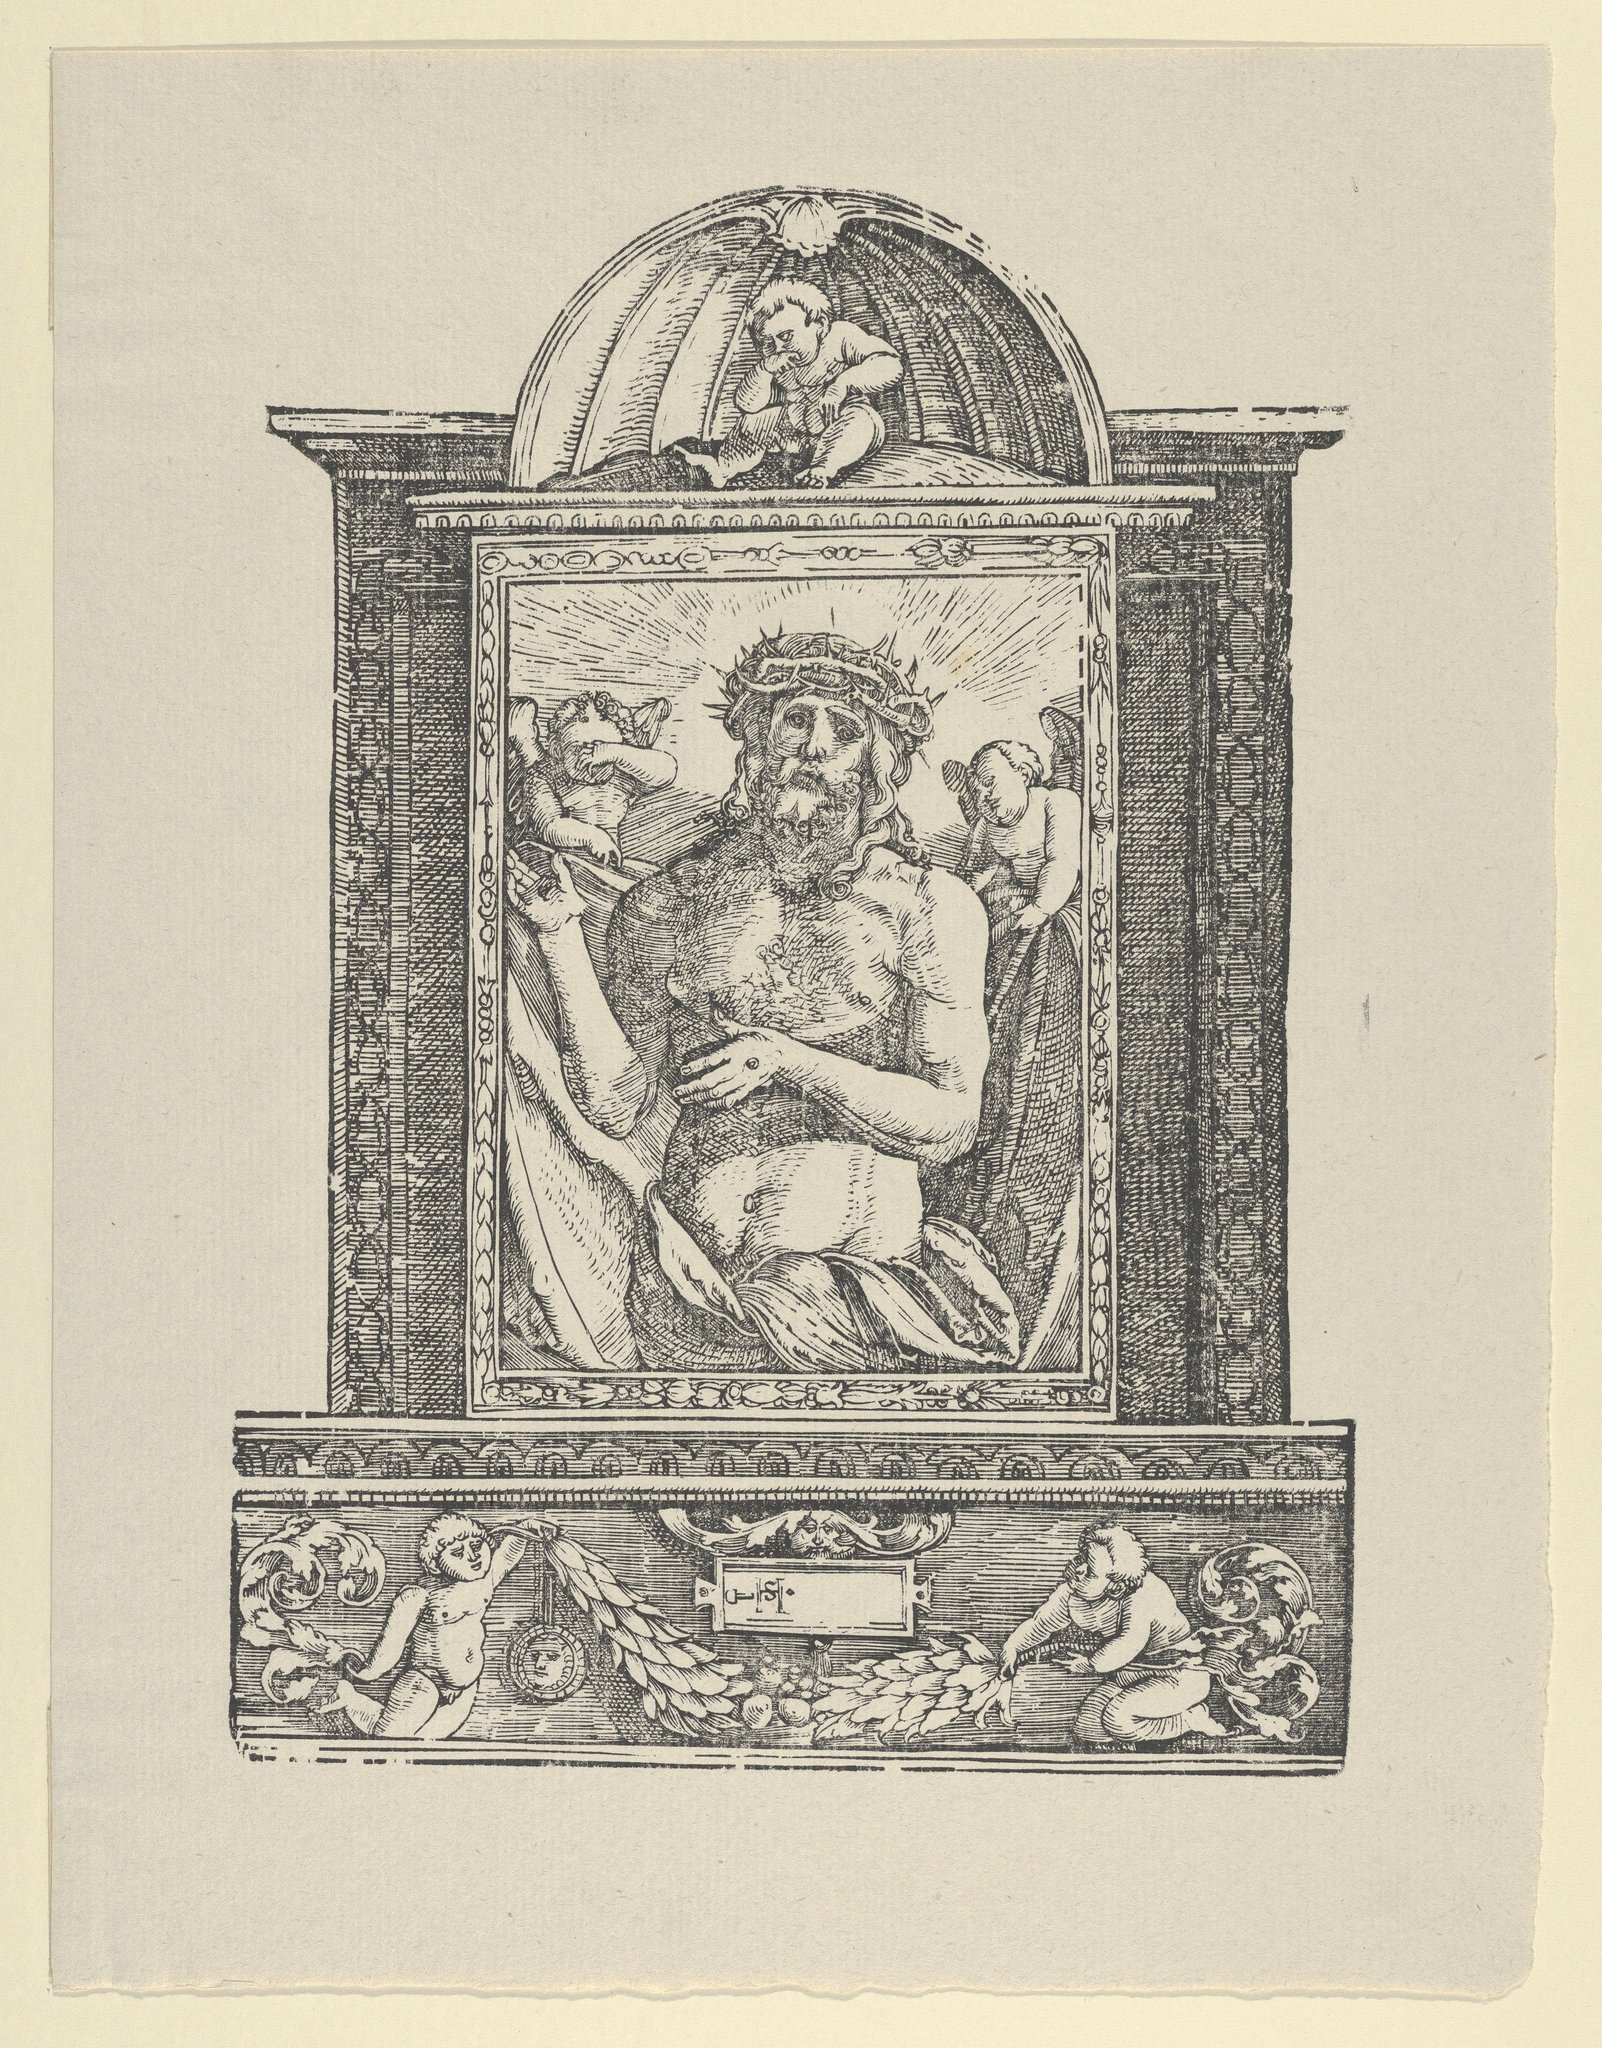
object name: print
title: Ecce Homo / Man of Sorrows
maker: hans schäufelein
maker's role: artist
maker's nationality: german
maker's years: 1480-1540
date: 1922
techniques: woodcut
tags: angels,christ